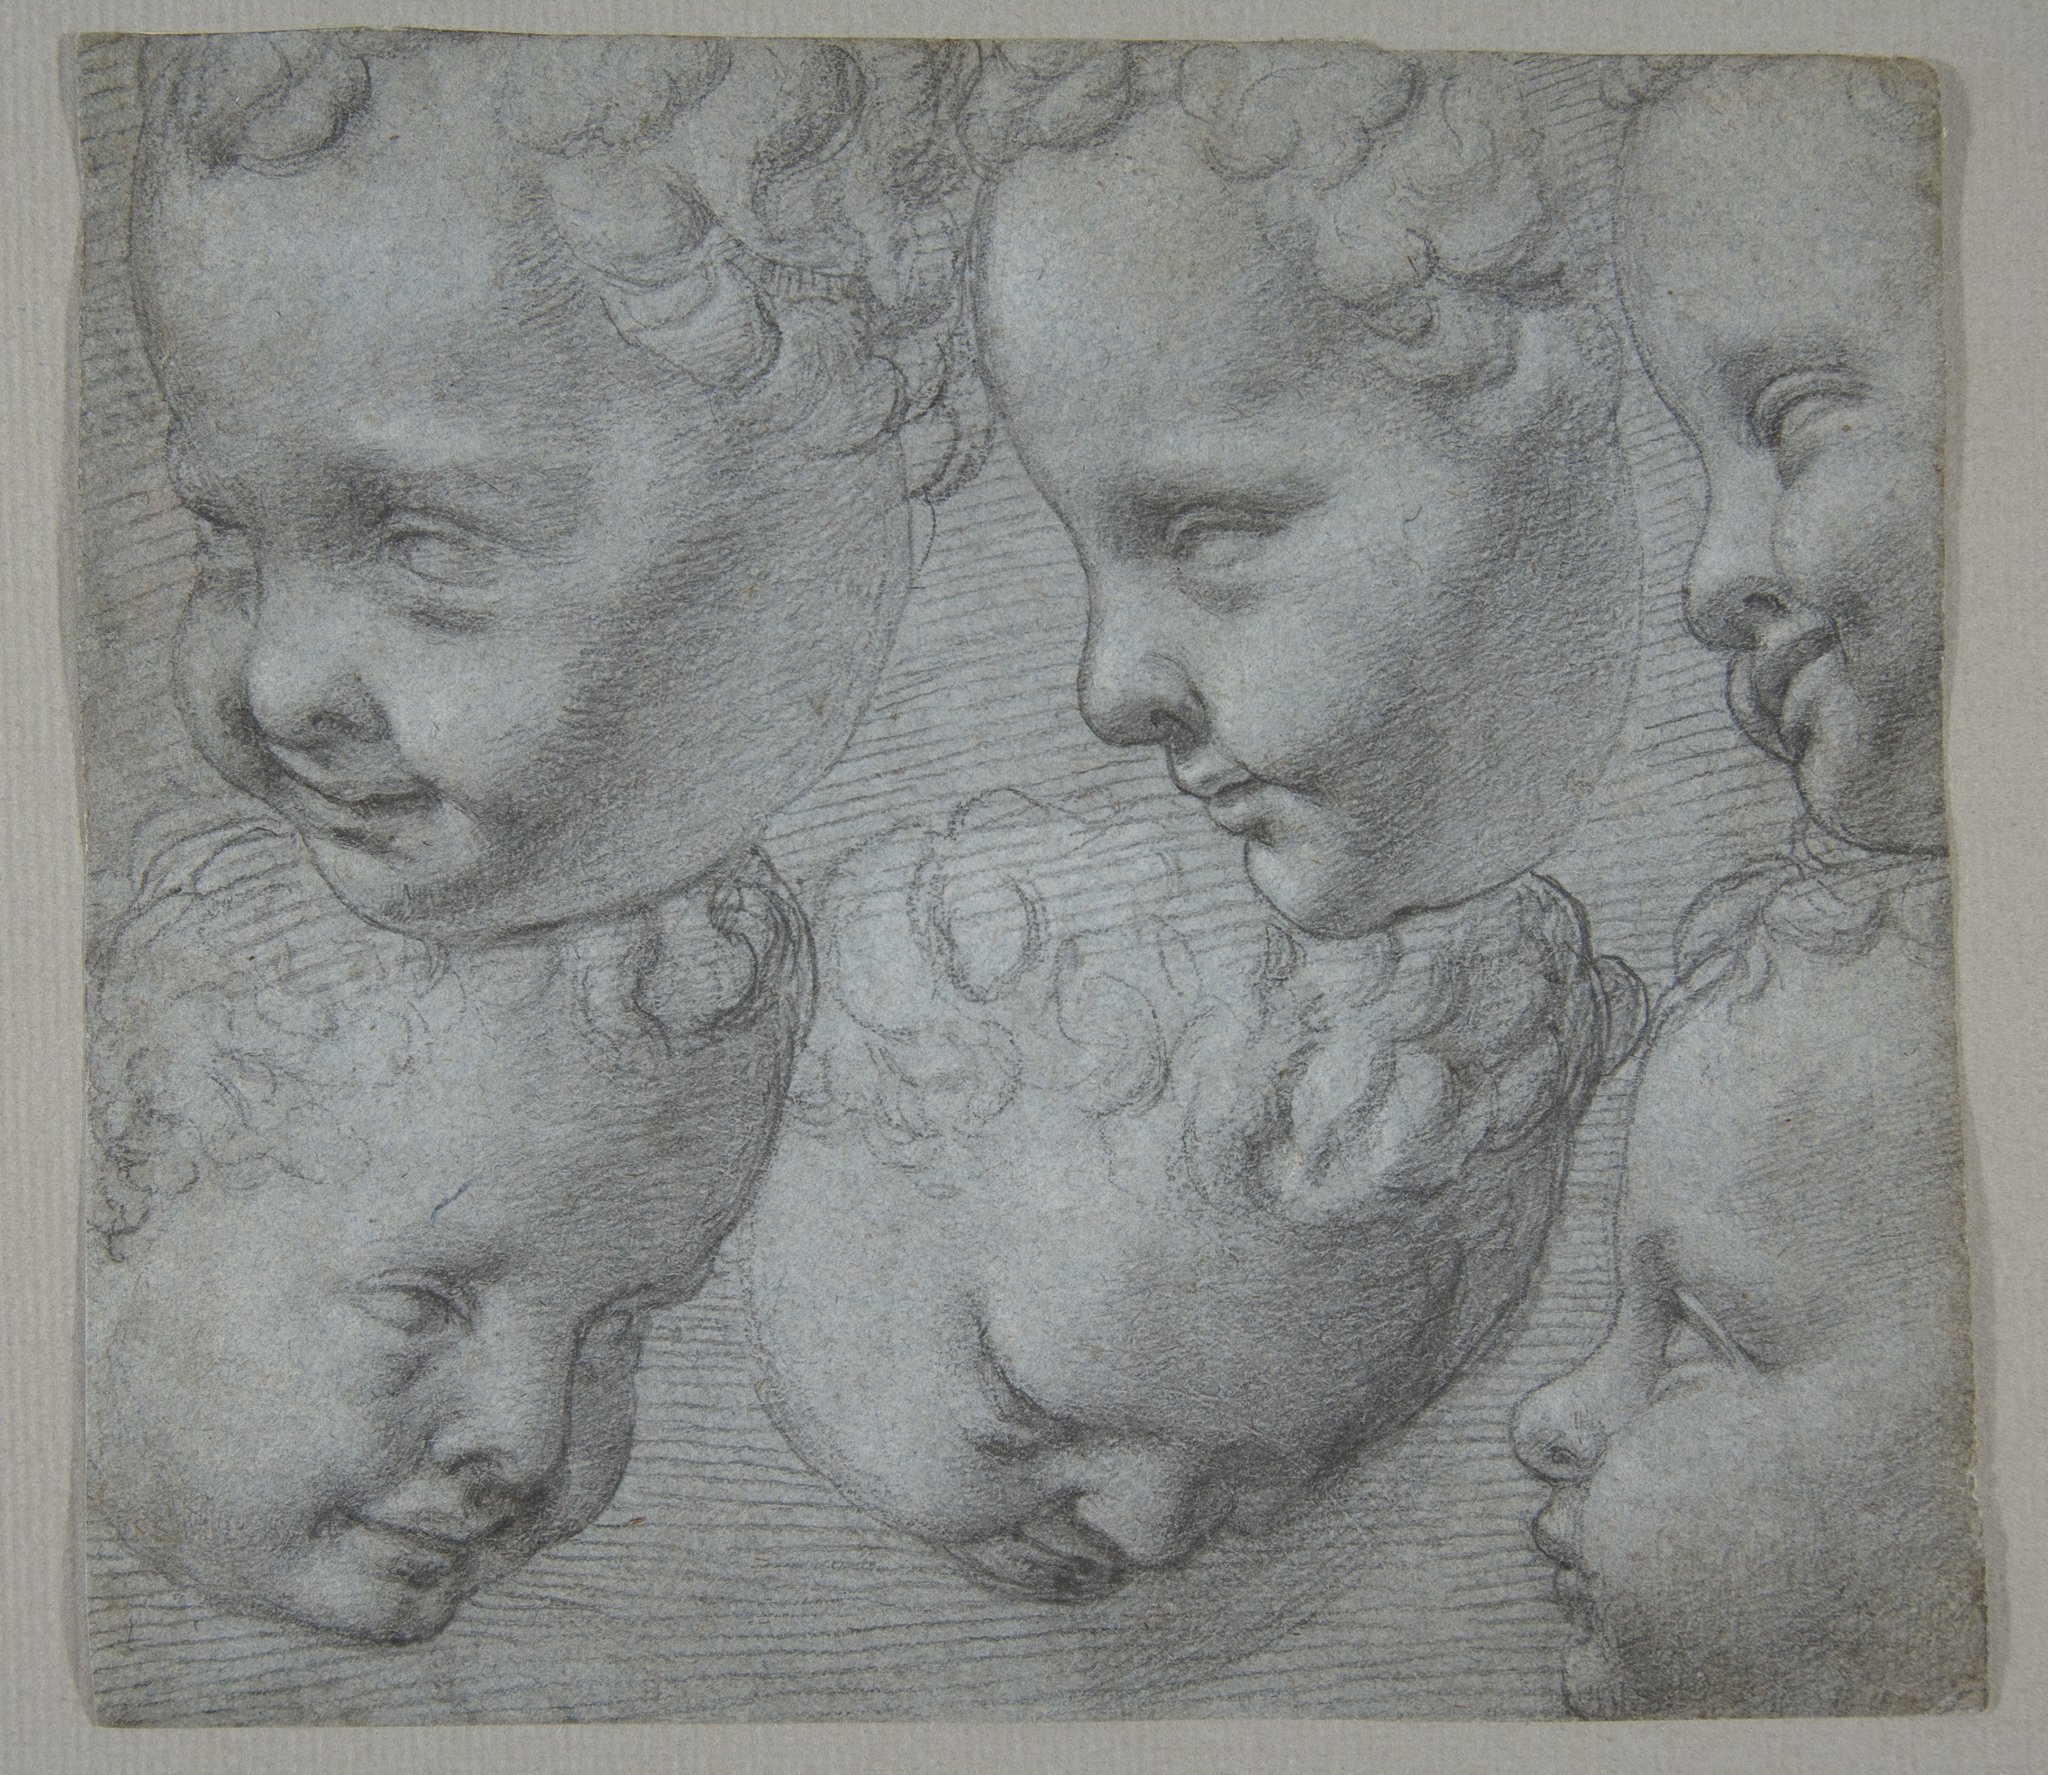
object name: drawing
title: Studies of the Head of an Infant (after a three-dimensional model)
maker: poppi (francesco morandini)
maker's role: artist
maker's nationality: italian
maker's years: 1544-1597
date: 1572-1574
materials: chalk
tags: heads,infants